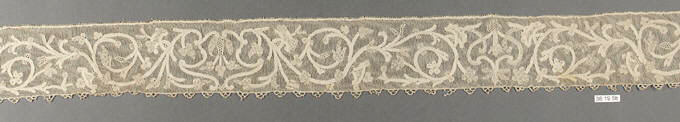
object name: hebrew ritual lace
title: Hebrew ritual lace (one of four)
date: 1701-1733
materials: silk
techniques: lace